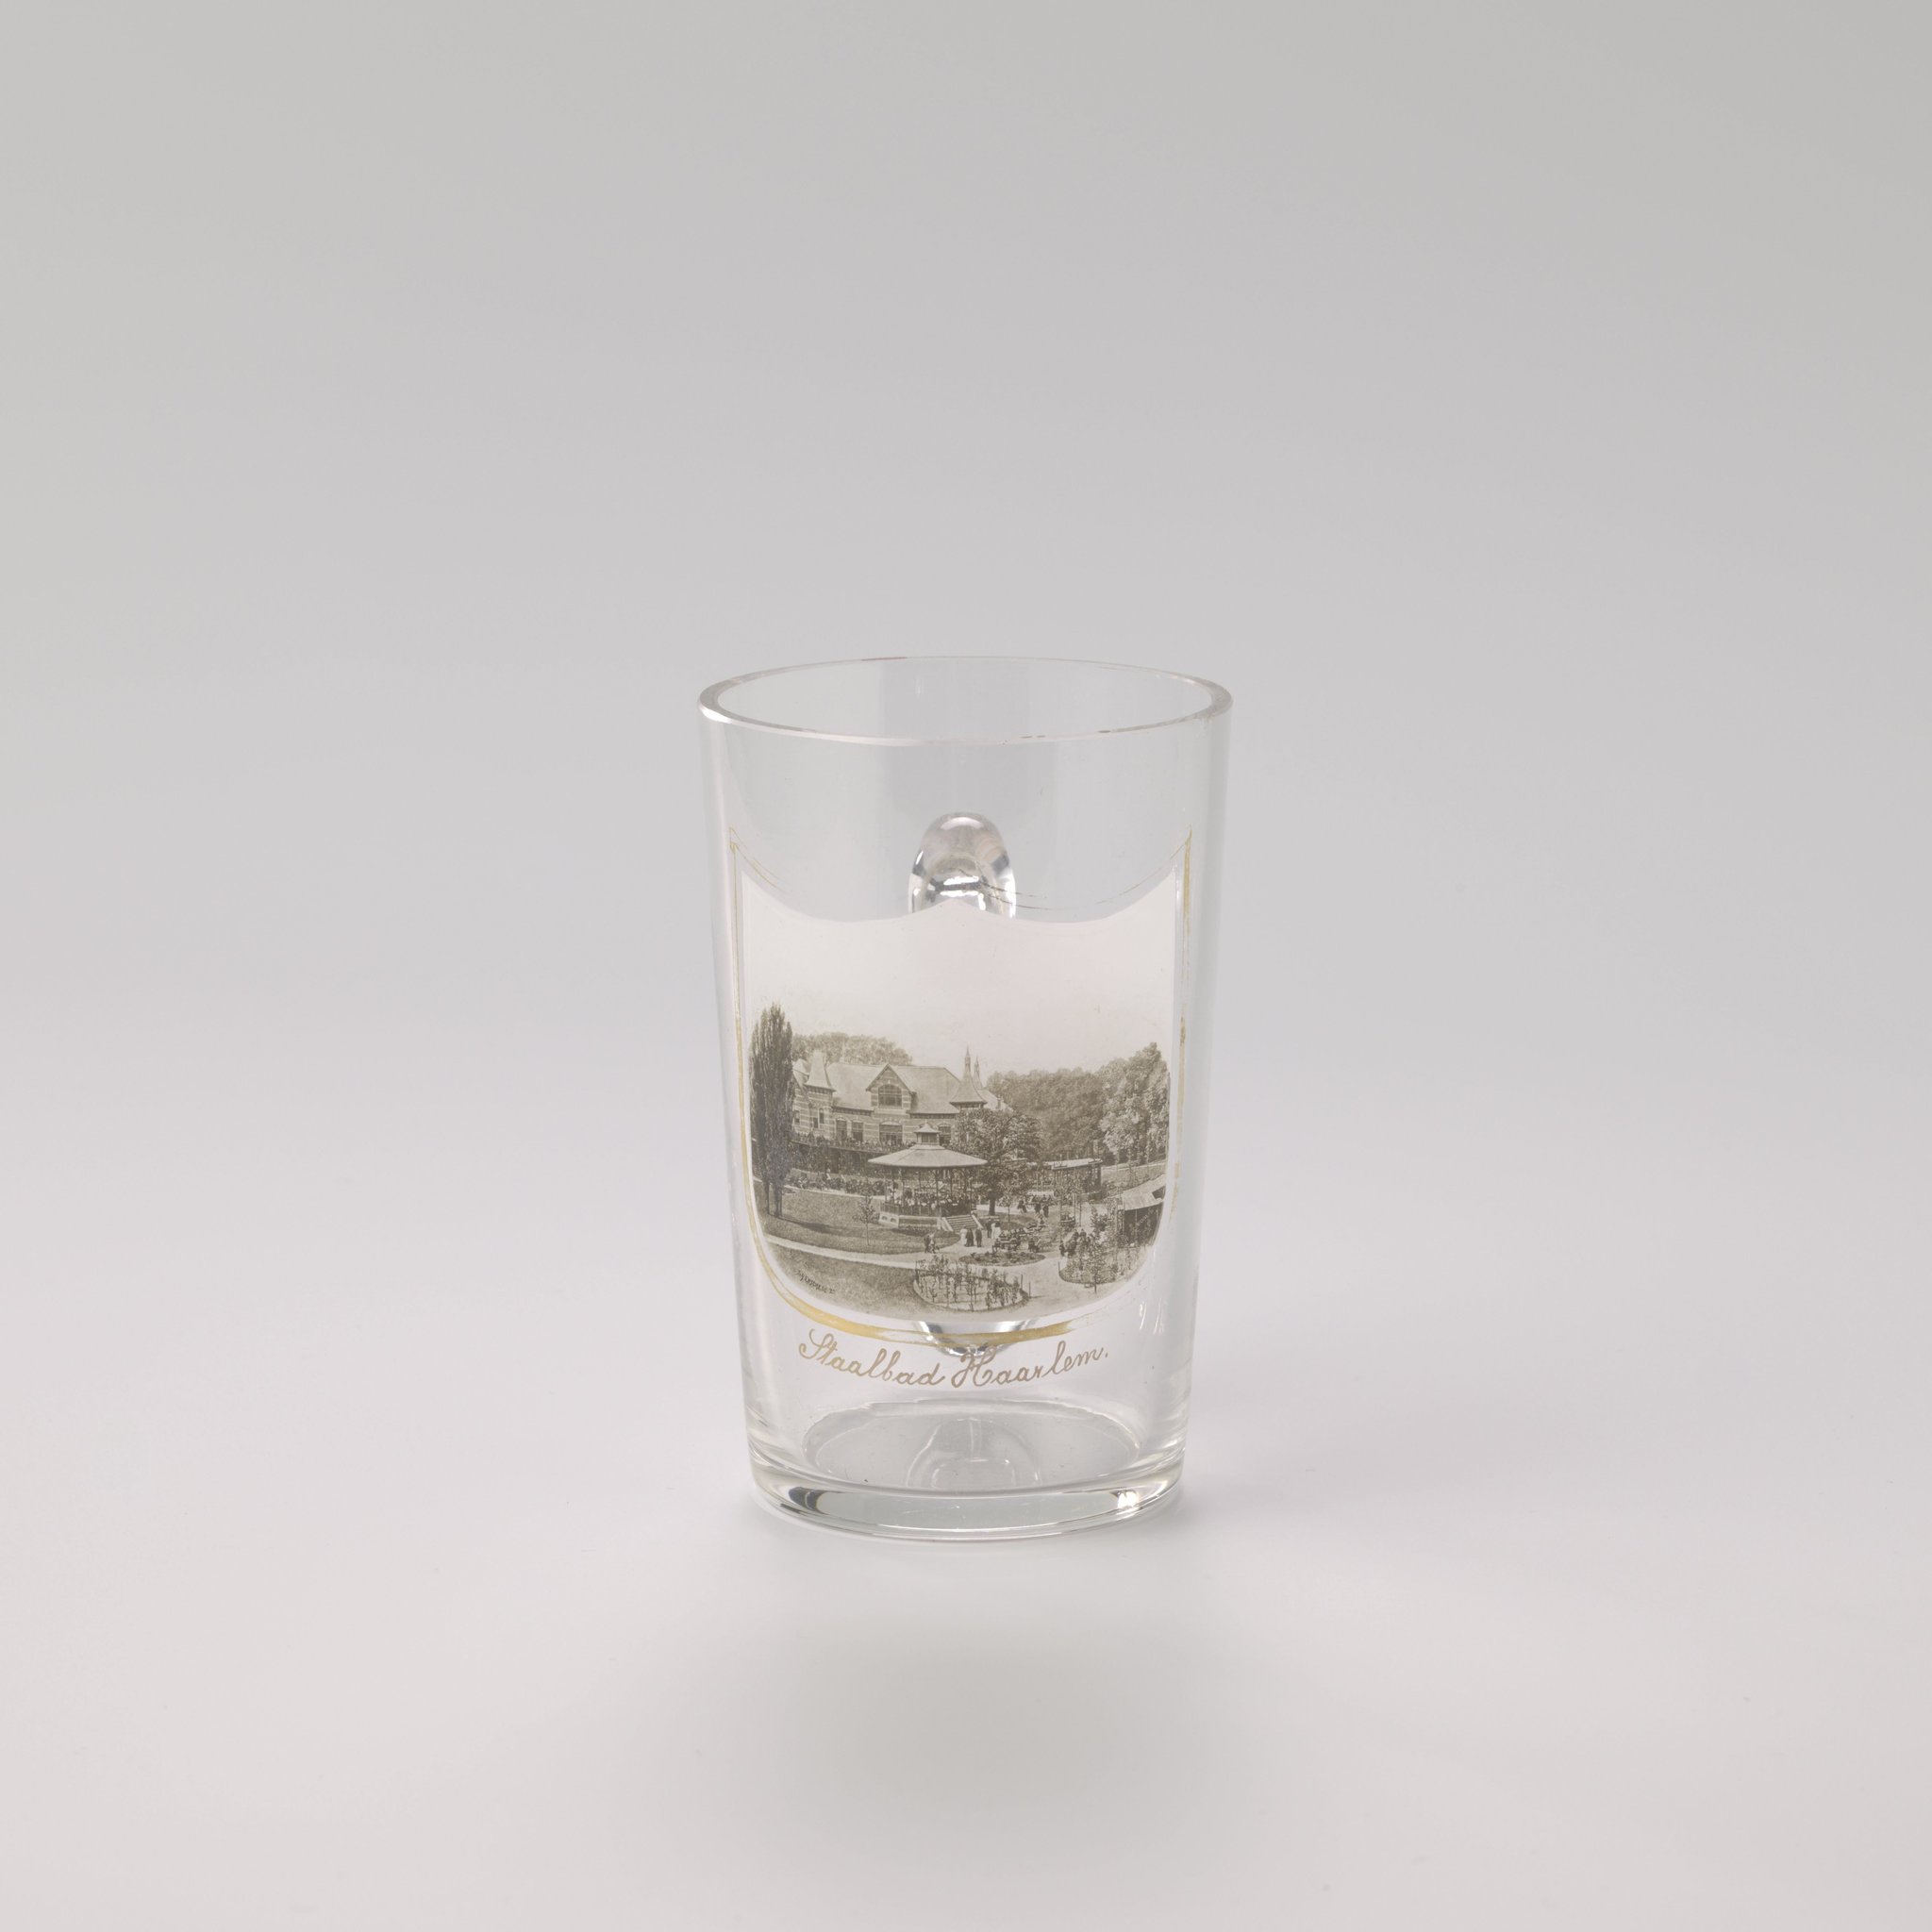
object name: photograph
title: Glas met foto van het Staalbad in Haarlem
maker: Anonymous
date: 1920-1940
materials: glass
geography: haarlem